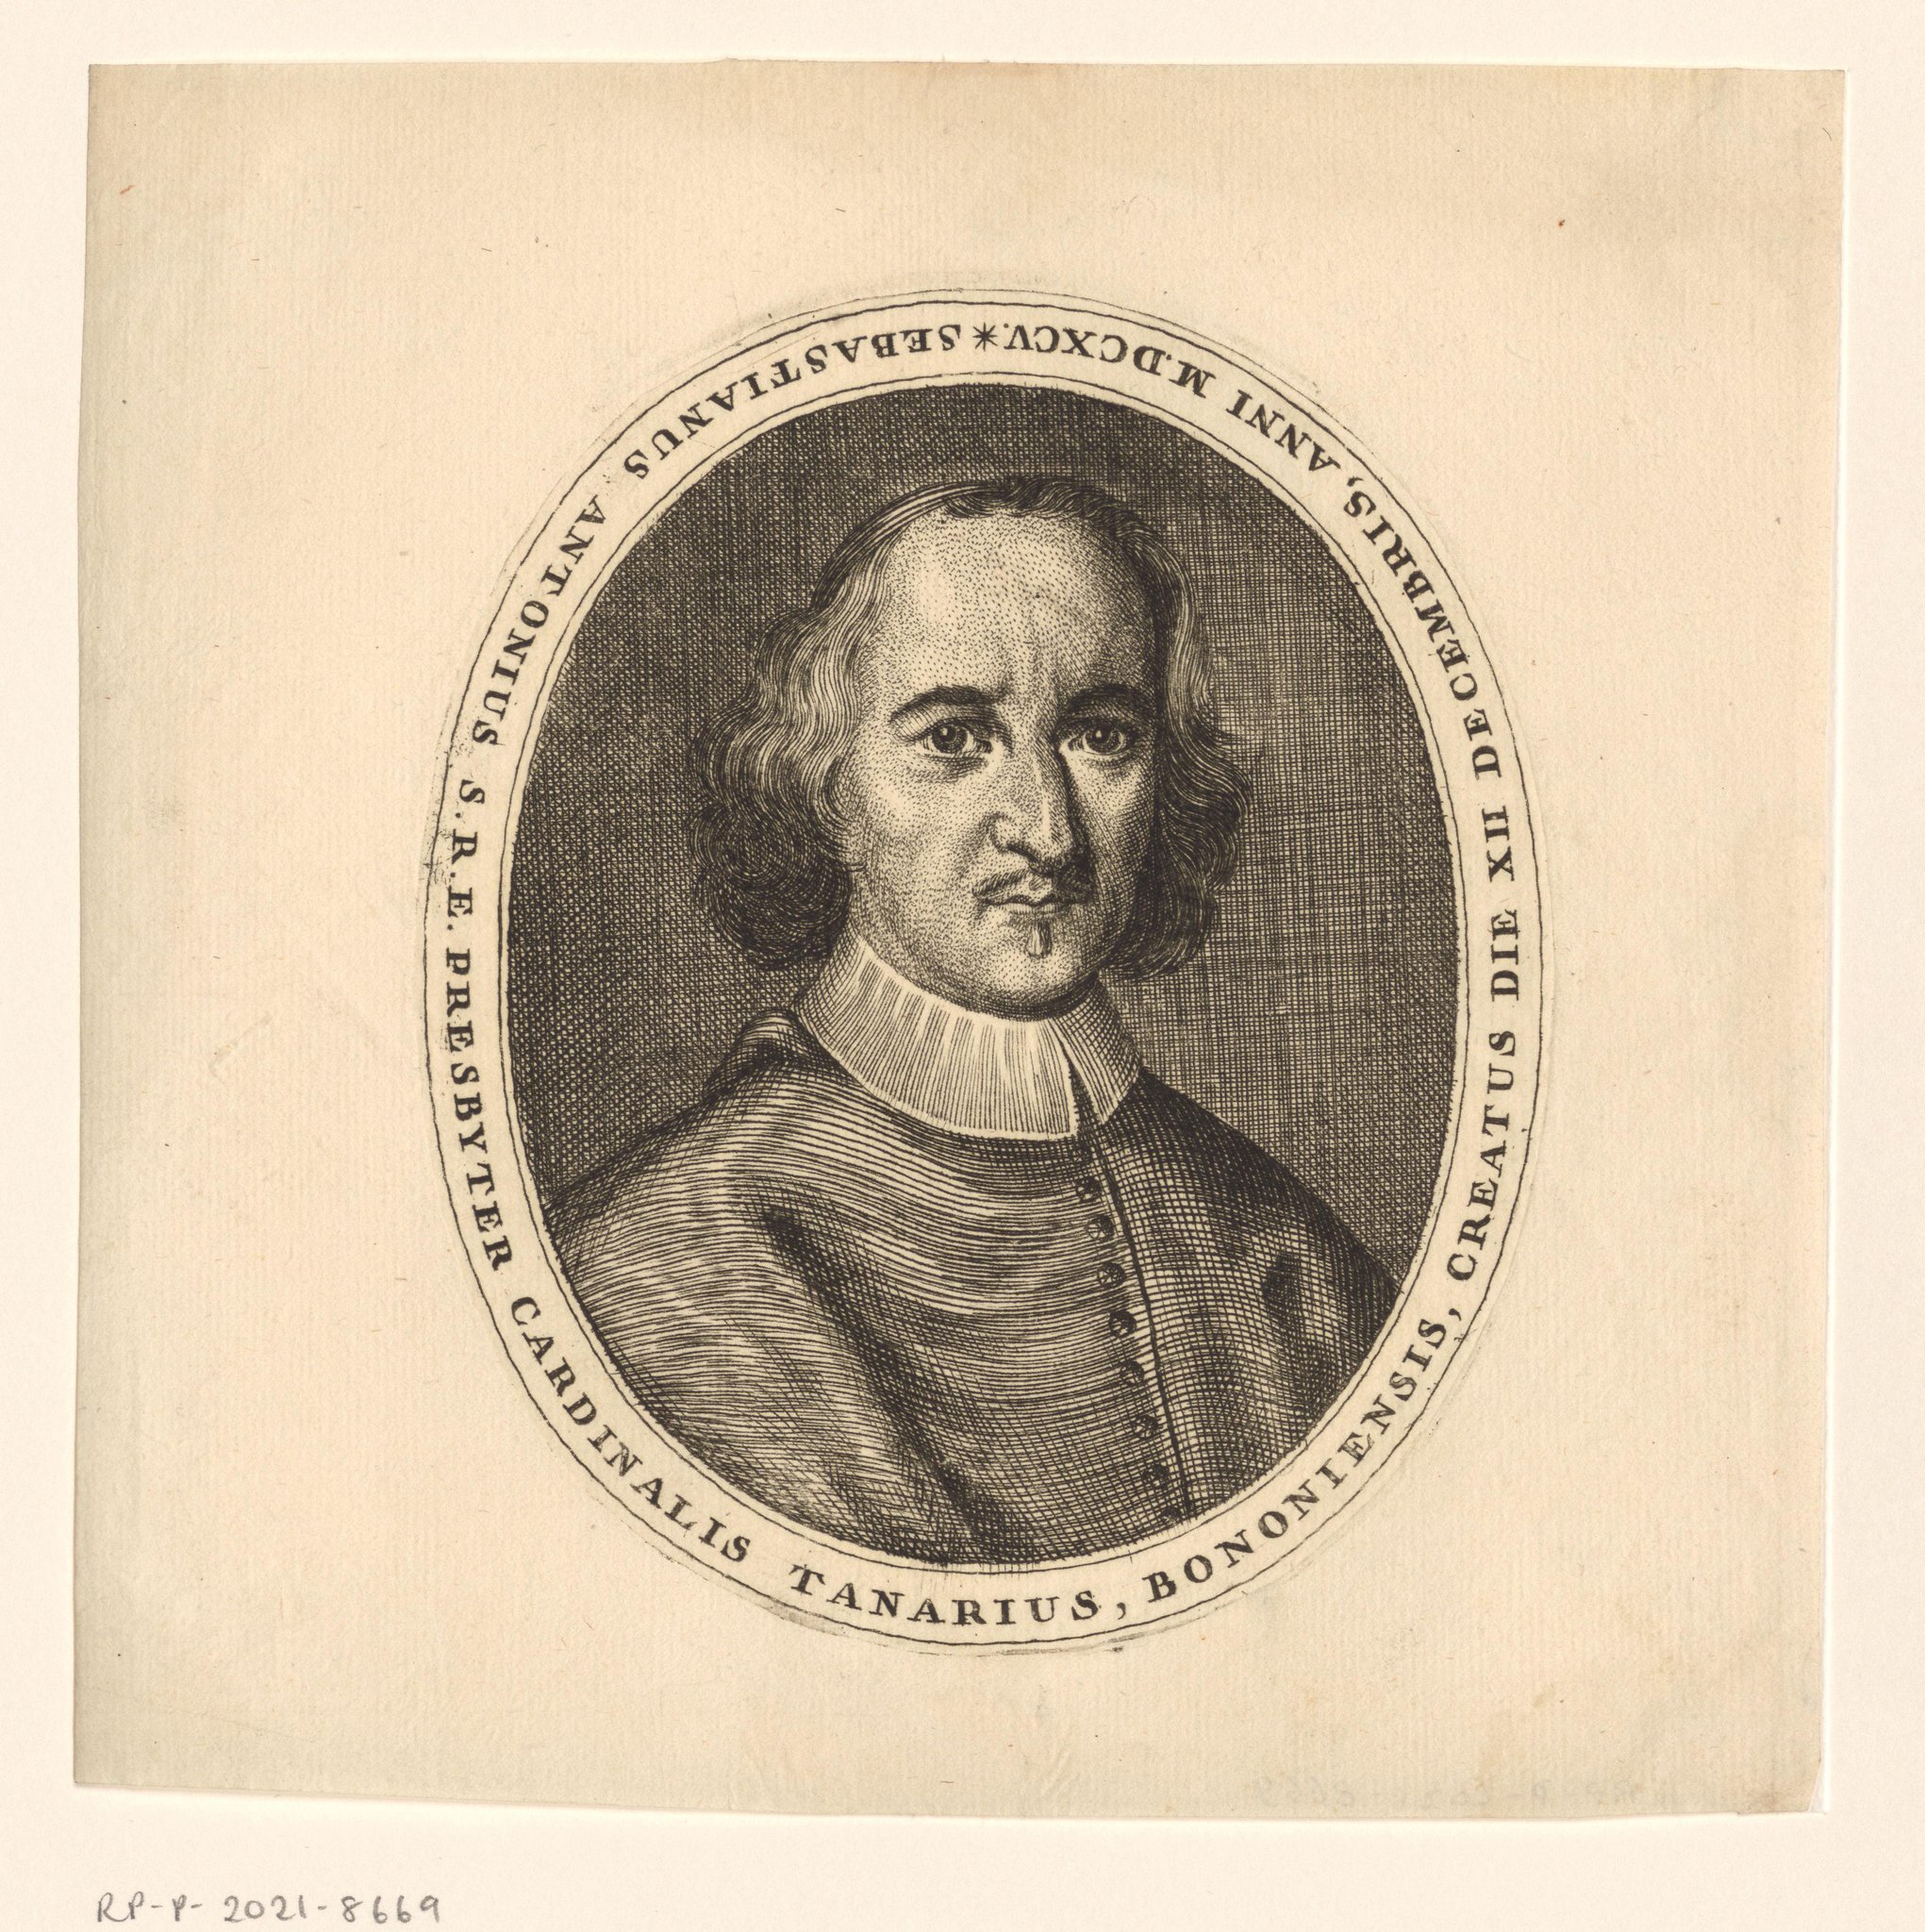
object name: print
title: Portret van Sebastiano Antonio Tanara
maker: Anonymous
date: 1695-1724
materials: paper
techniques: engraving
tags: cardinal, historical persons